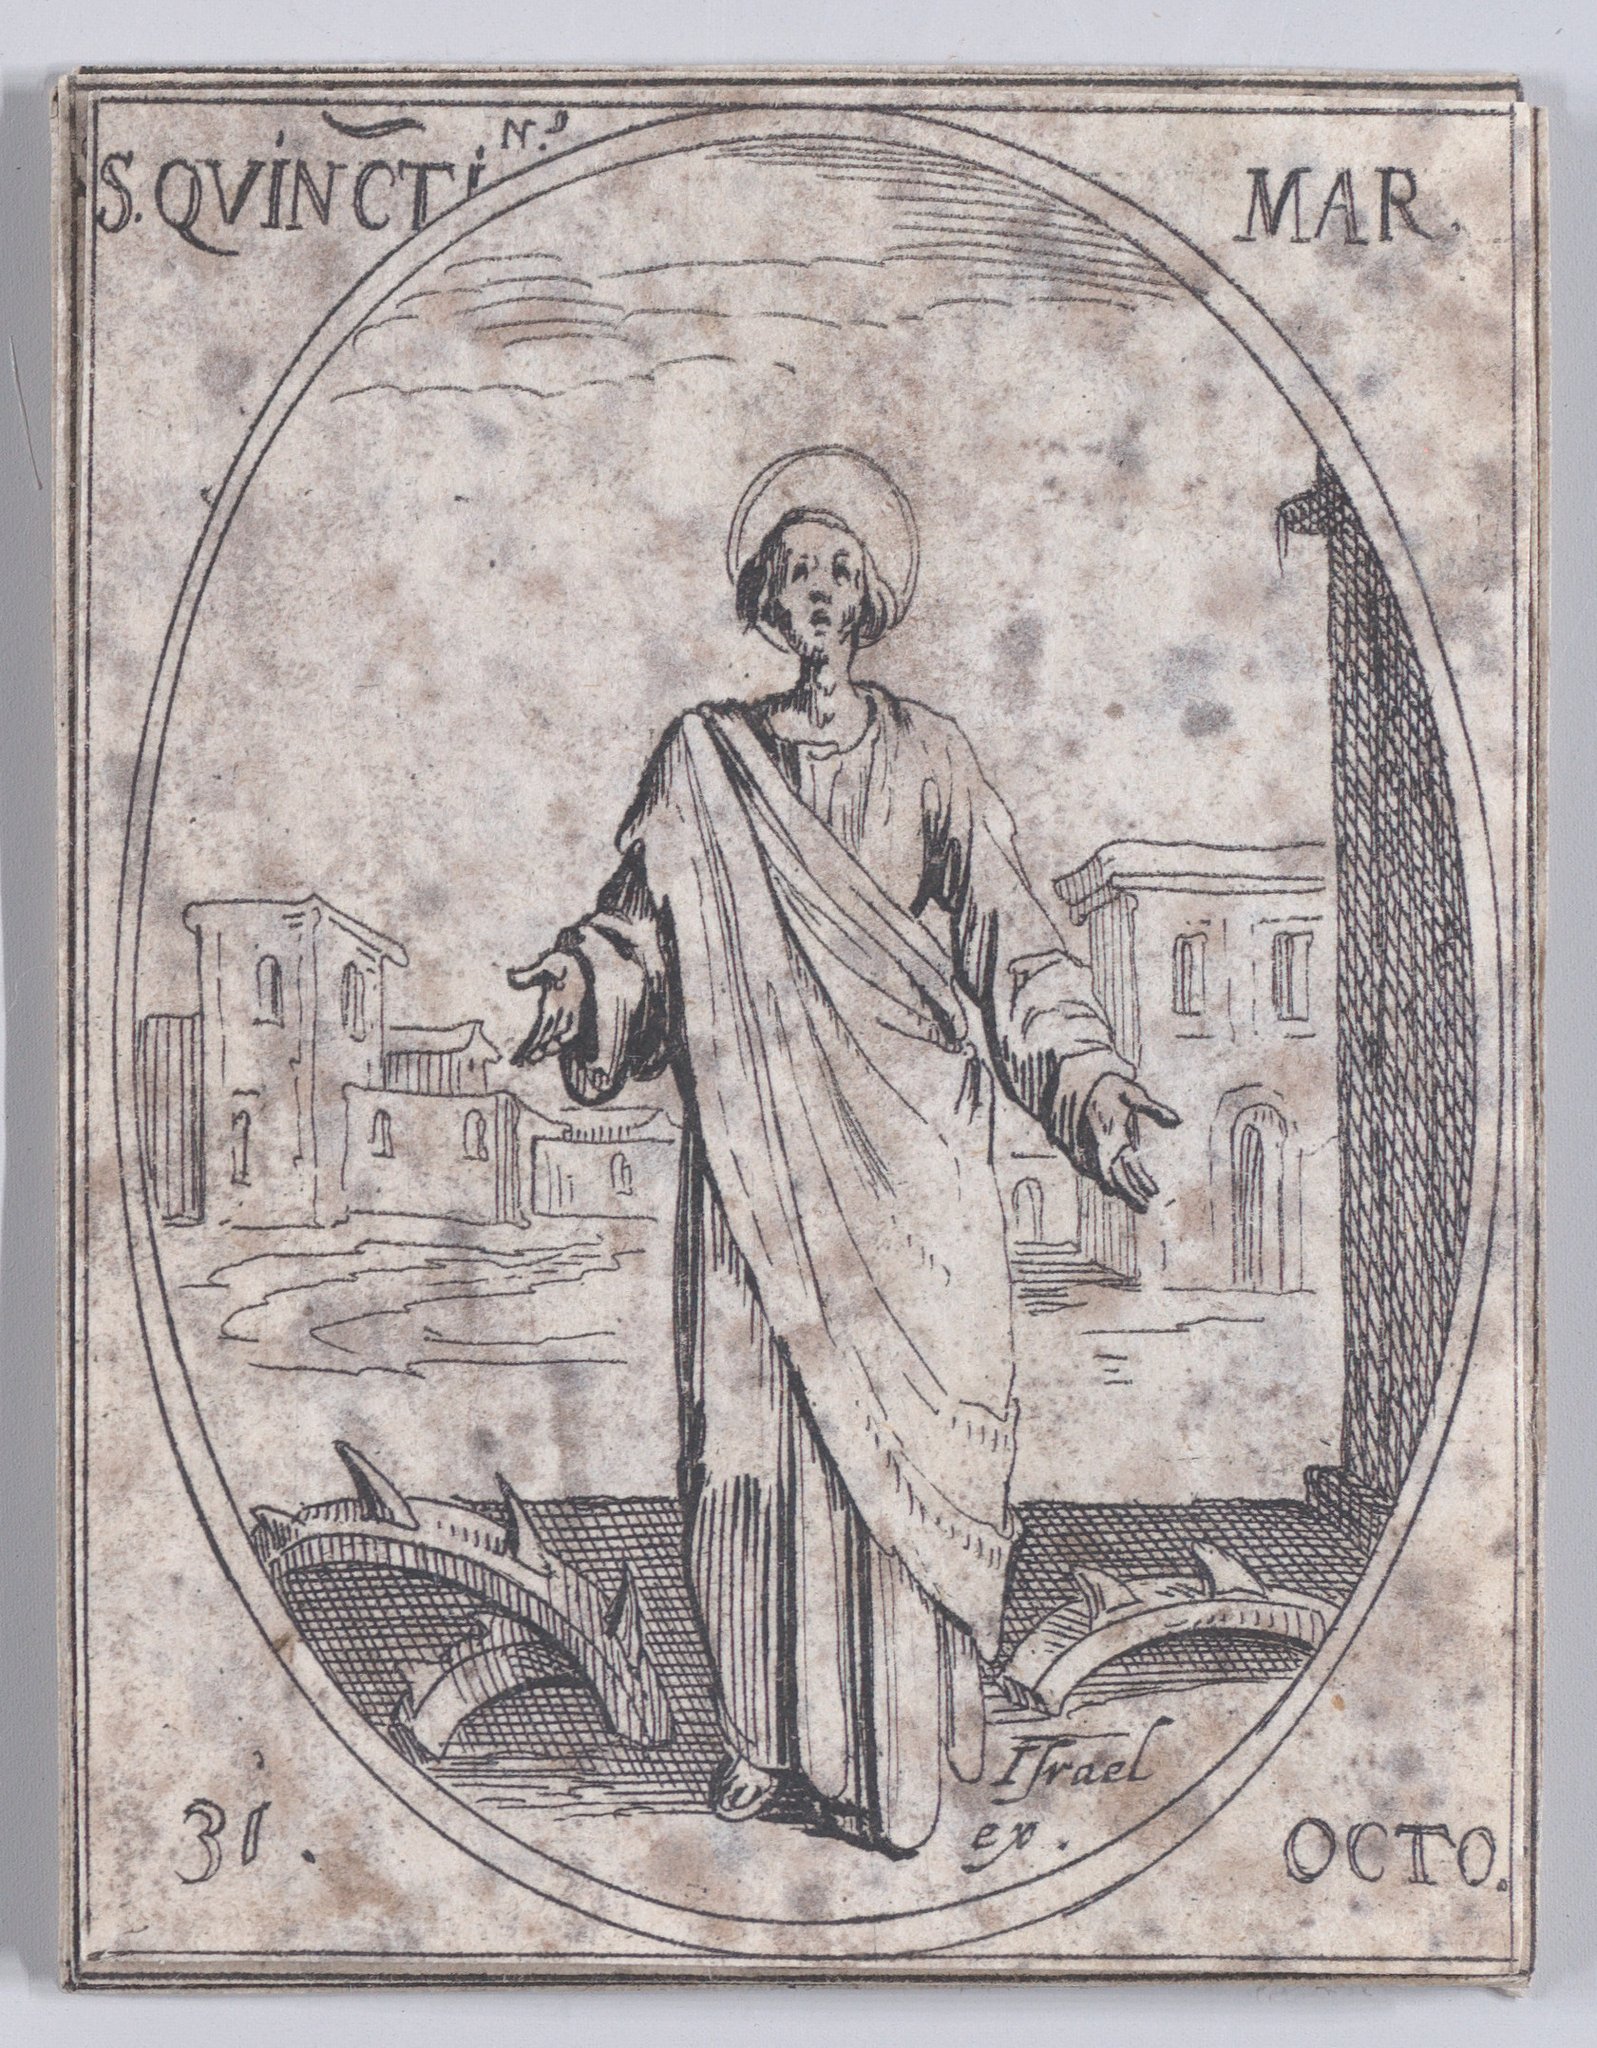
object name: print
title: S. Quentin, martyr (St. Quintinus, Martyr), October 31st, from "Les Images De Tous Les Saincts et Saintes de L'Année" (Images of All of the Saints and Religious Events of the Year)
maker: jacques callot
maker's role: artist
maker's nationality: french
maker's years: 1592-1635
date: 1636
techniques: etching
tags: men,saints